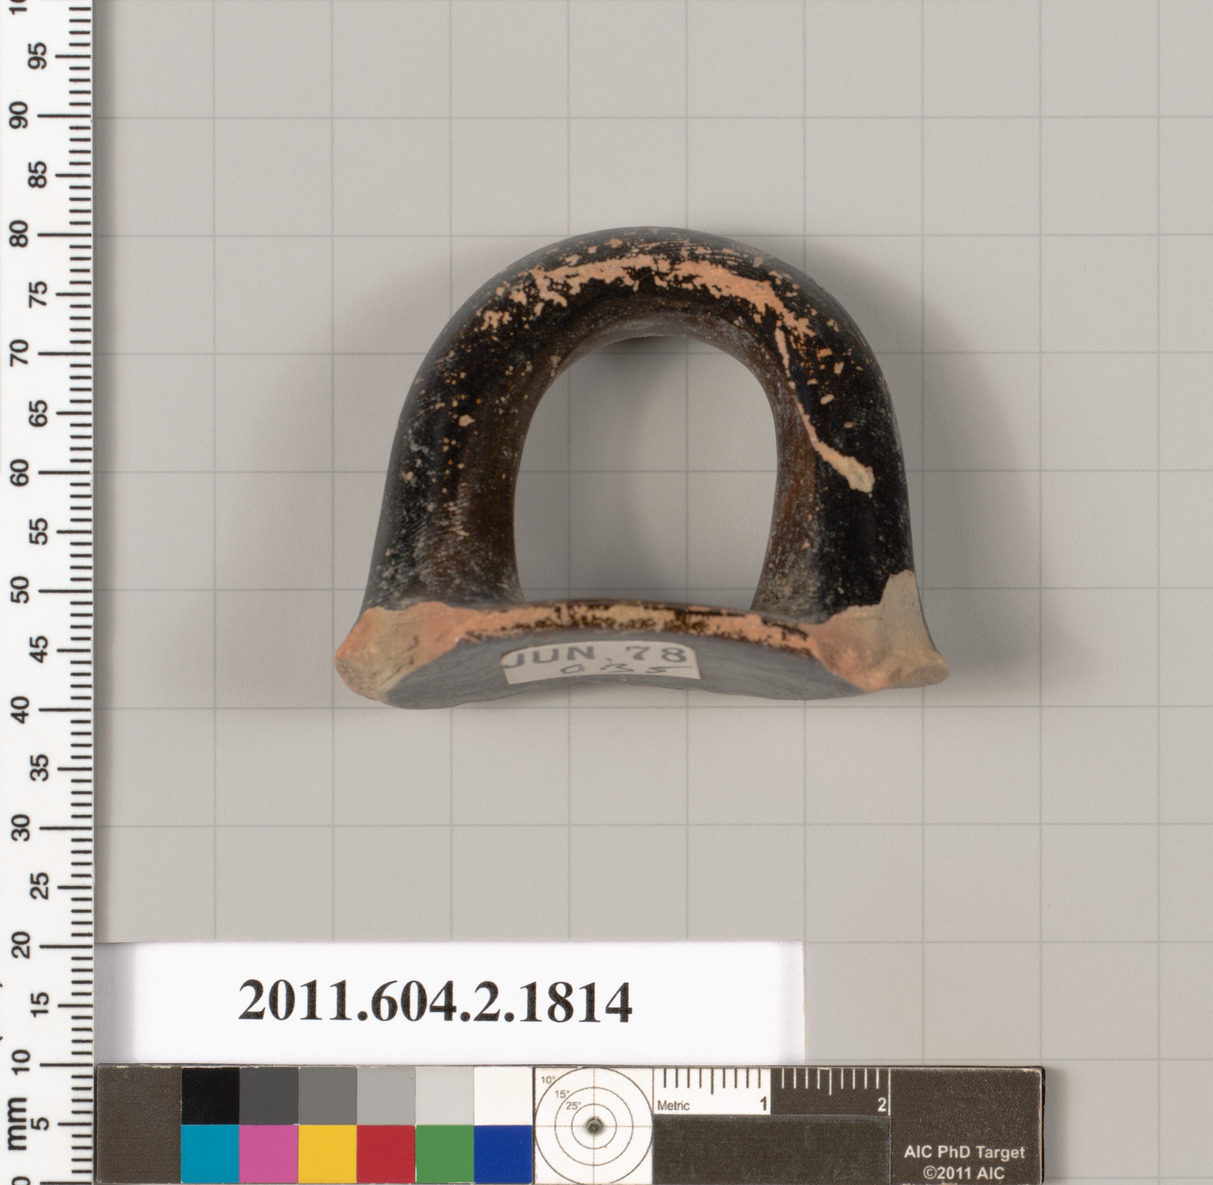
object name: skyphos fragment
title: Terracotta fragment of a skyphos (deep drinking cup)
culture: greek, attic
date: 500-401 BCE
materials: terracotta